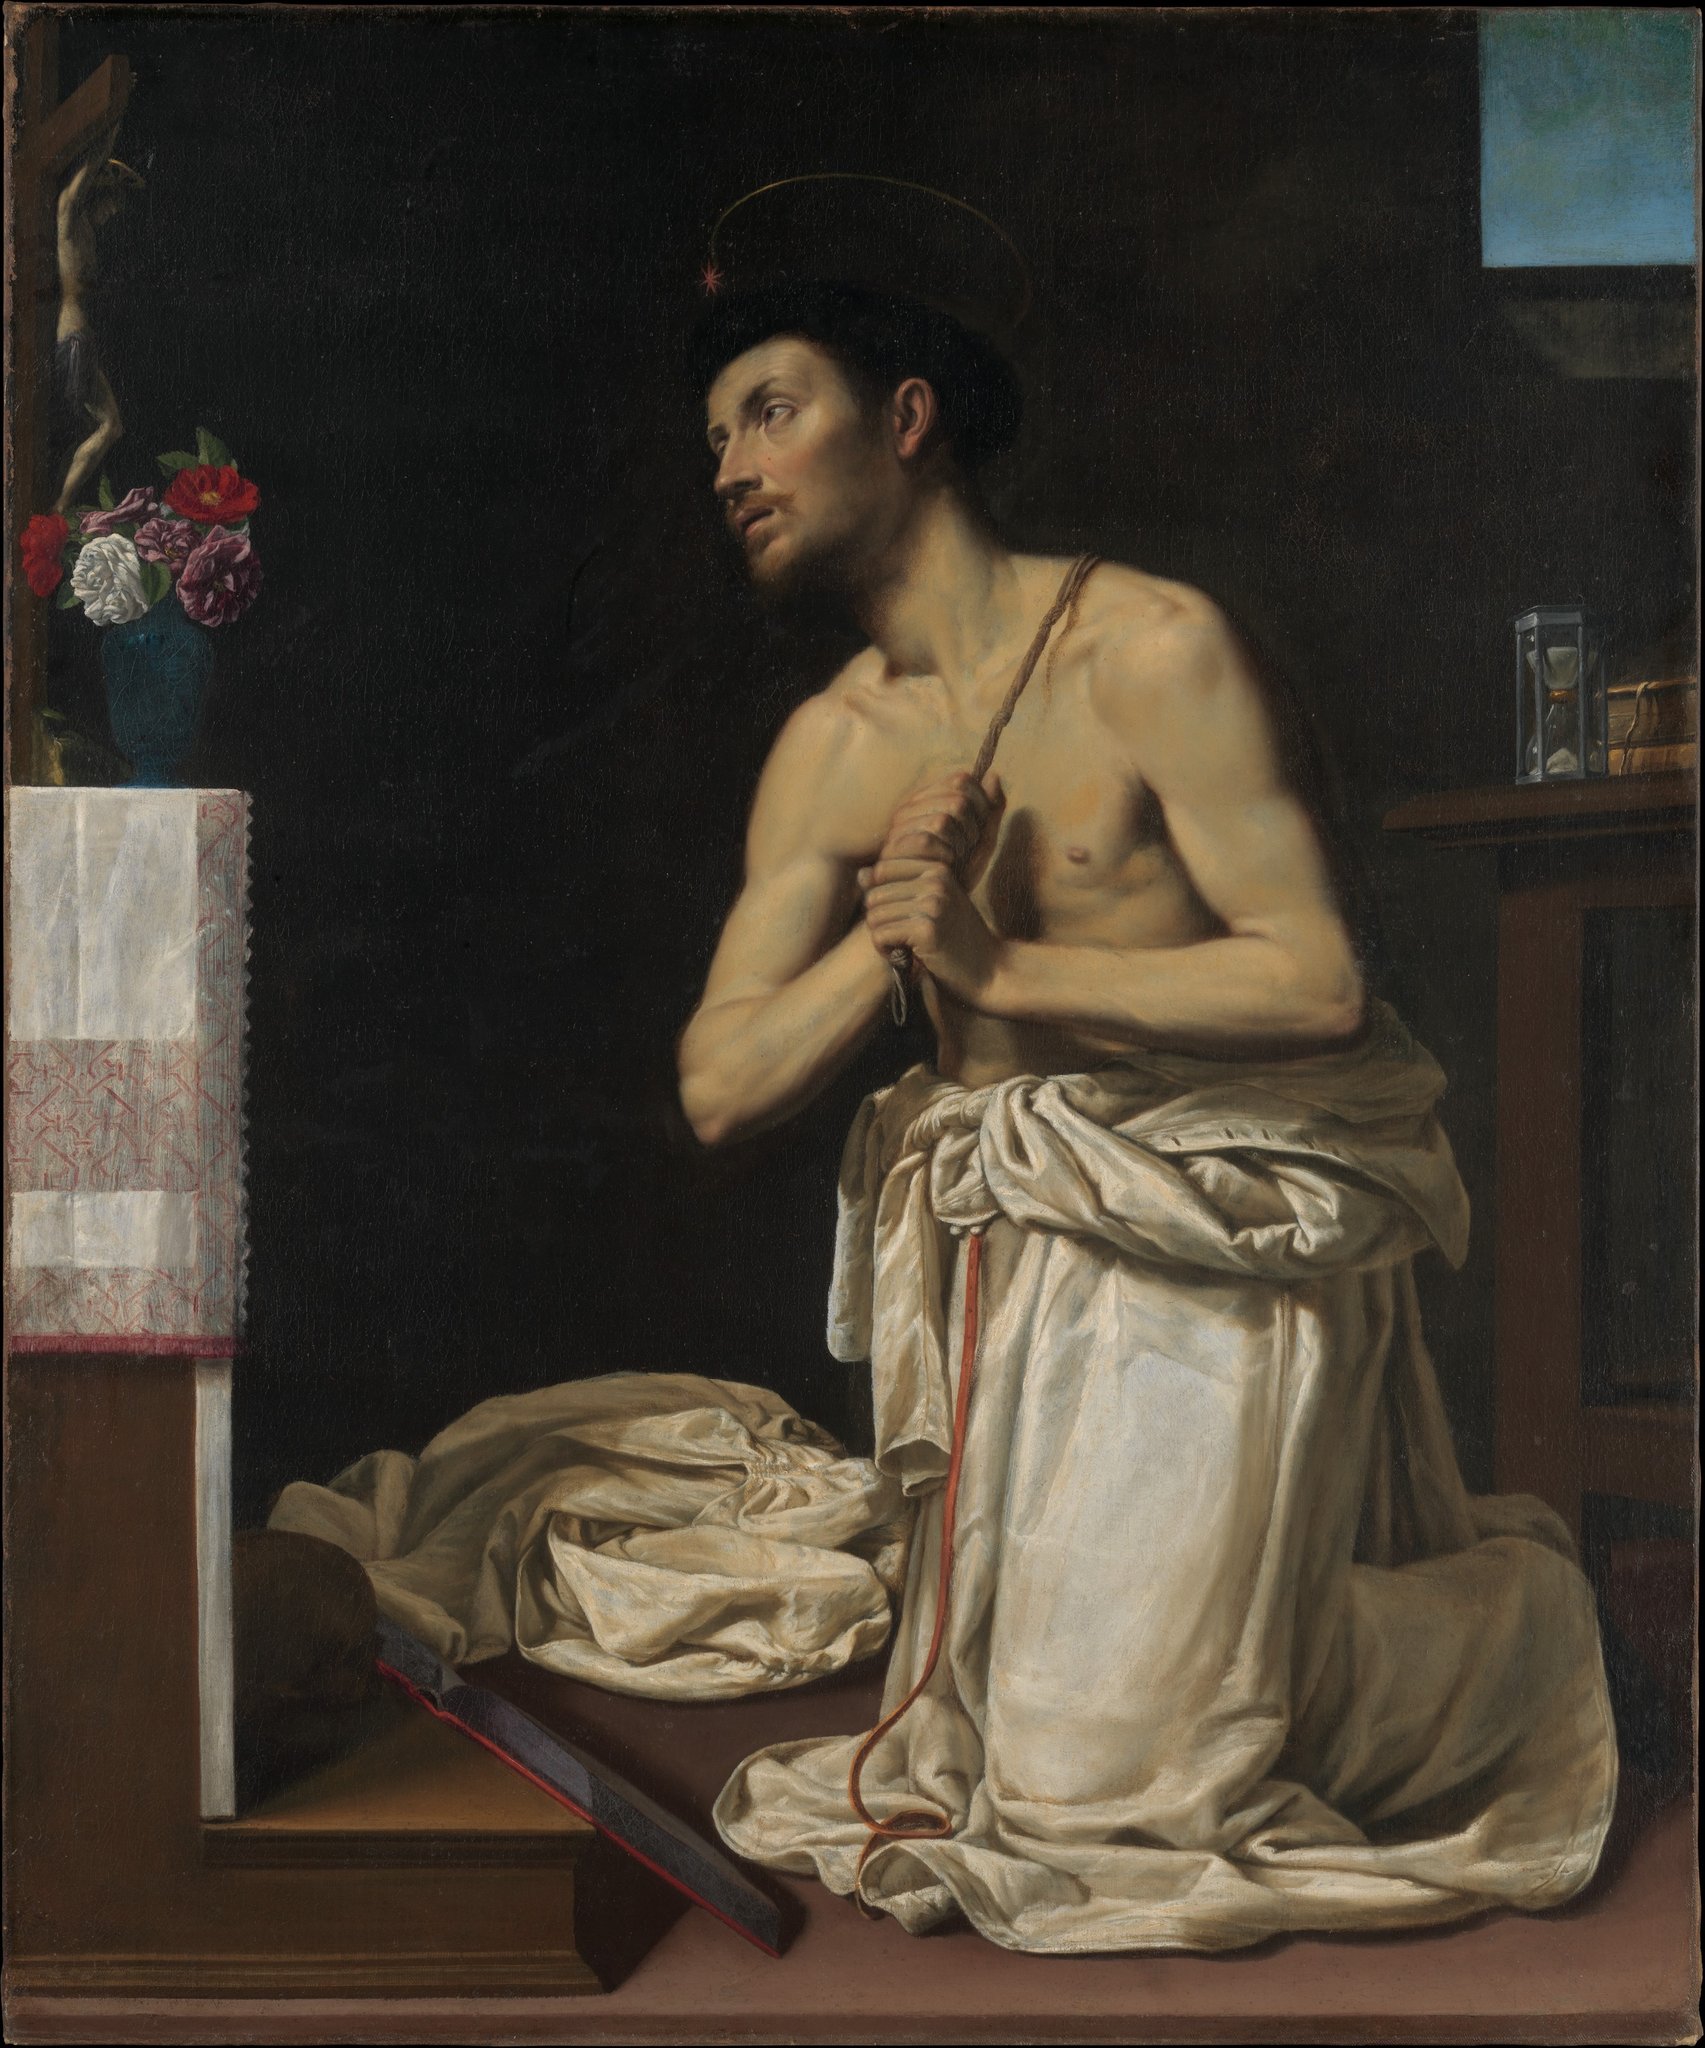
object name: painting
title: Saint Dominic in Penitence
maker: filippo tarchiani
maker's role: artist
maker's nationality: italian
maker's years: 1576-1645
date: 1607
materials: canvas, oil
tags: altars,men,saints